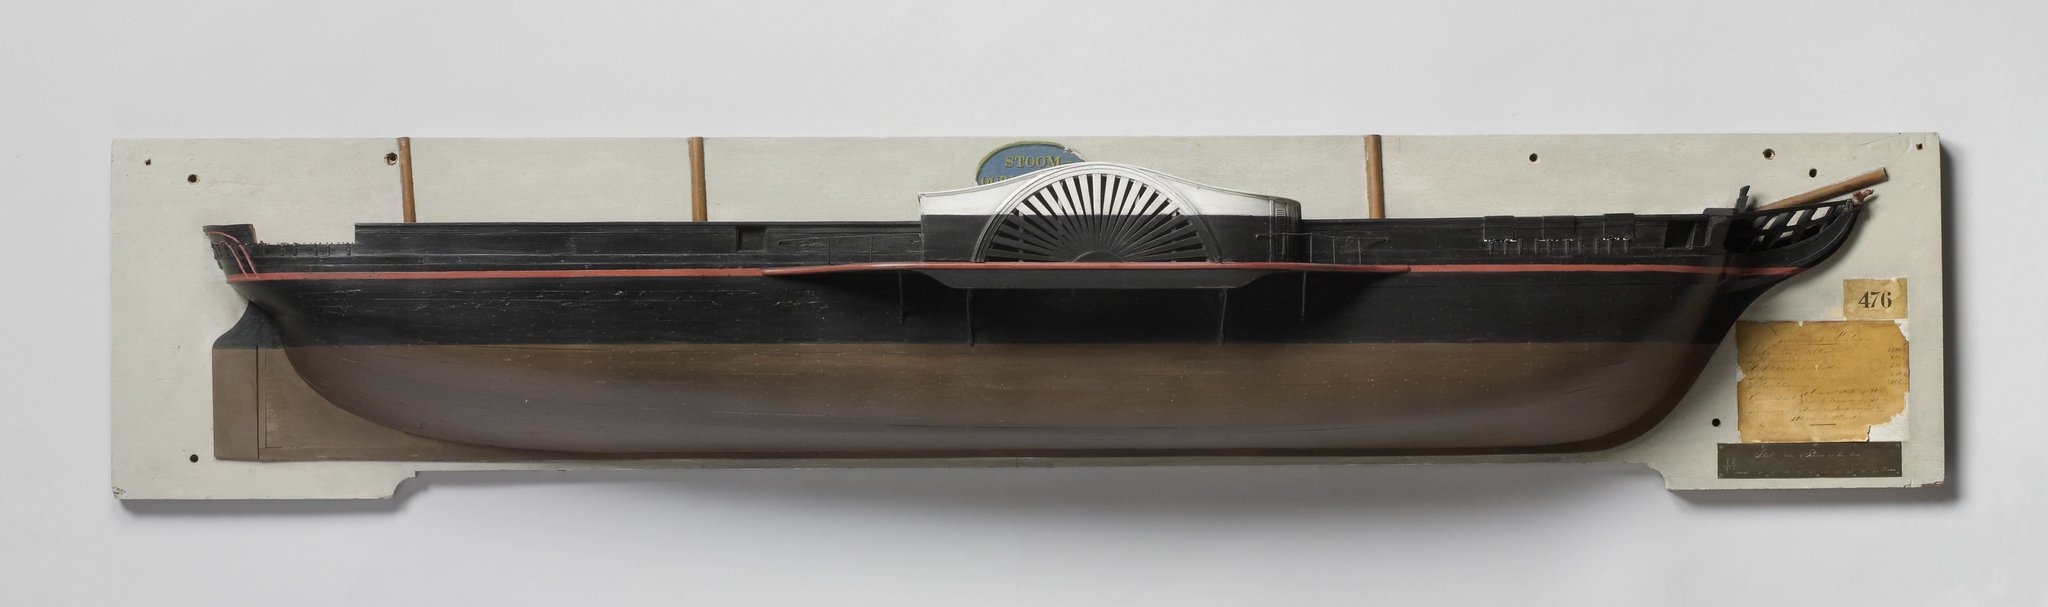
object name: builder's model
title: Half Model of a Paddle Steamer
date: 1837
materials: brass, wood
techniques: polychromy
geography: flushing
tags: cerberus (schip)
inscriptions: label, centre right: ‘476’ former inventory label, scale, bottom right: brass scale in inches, inscription, bottom right, on a piece of paper, in ink: ‘Voornaamste Afmetingen. / [followed by measurements and armament]’, inscription, top centre, on an oval blue label: ‘STOOM- / OORLOGSCHIP / CERBERUS’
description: Het raderstoomschip van 3 stukken Cerberus, lang 45.2 m, werd in 1834-1836 door C. Soetermeer te Vlissingen gebouwd. De machines kwamen van de Suriname (1827). Zij werd eerst als sleepboot gebruikt in Hellevoetsluis en Vlissingen, later als jager bij de haringvloot. In 1857 tot kolenhulk ingericht.